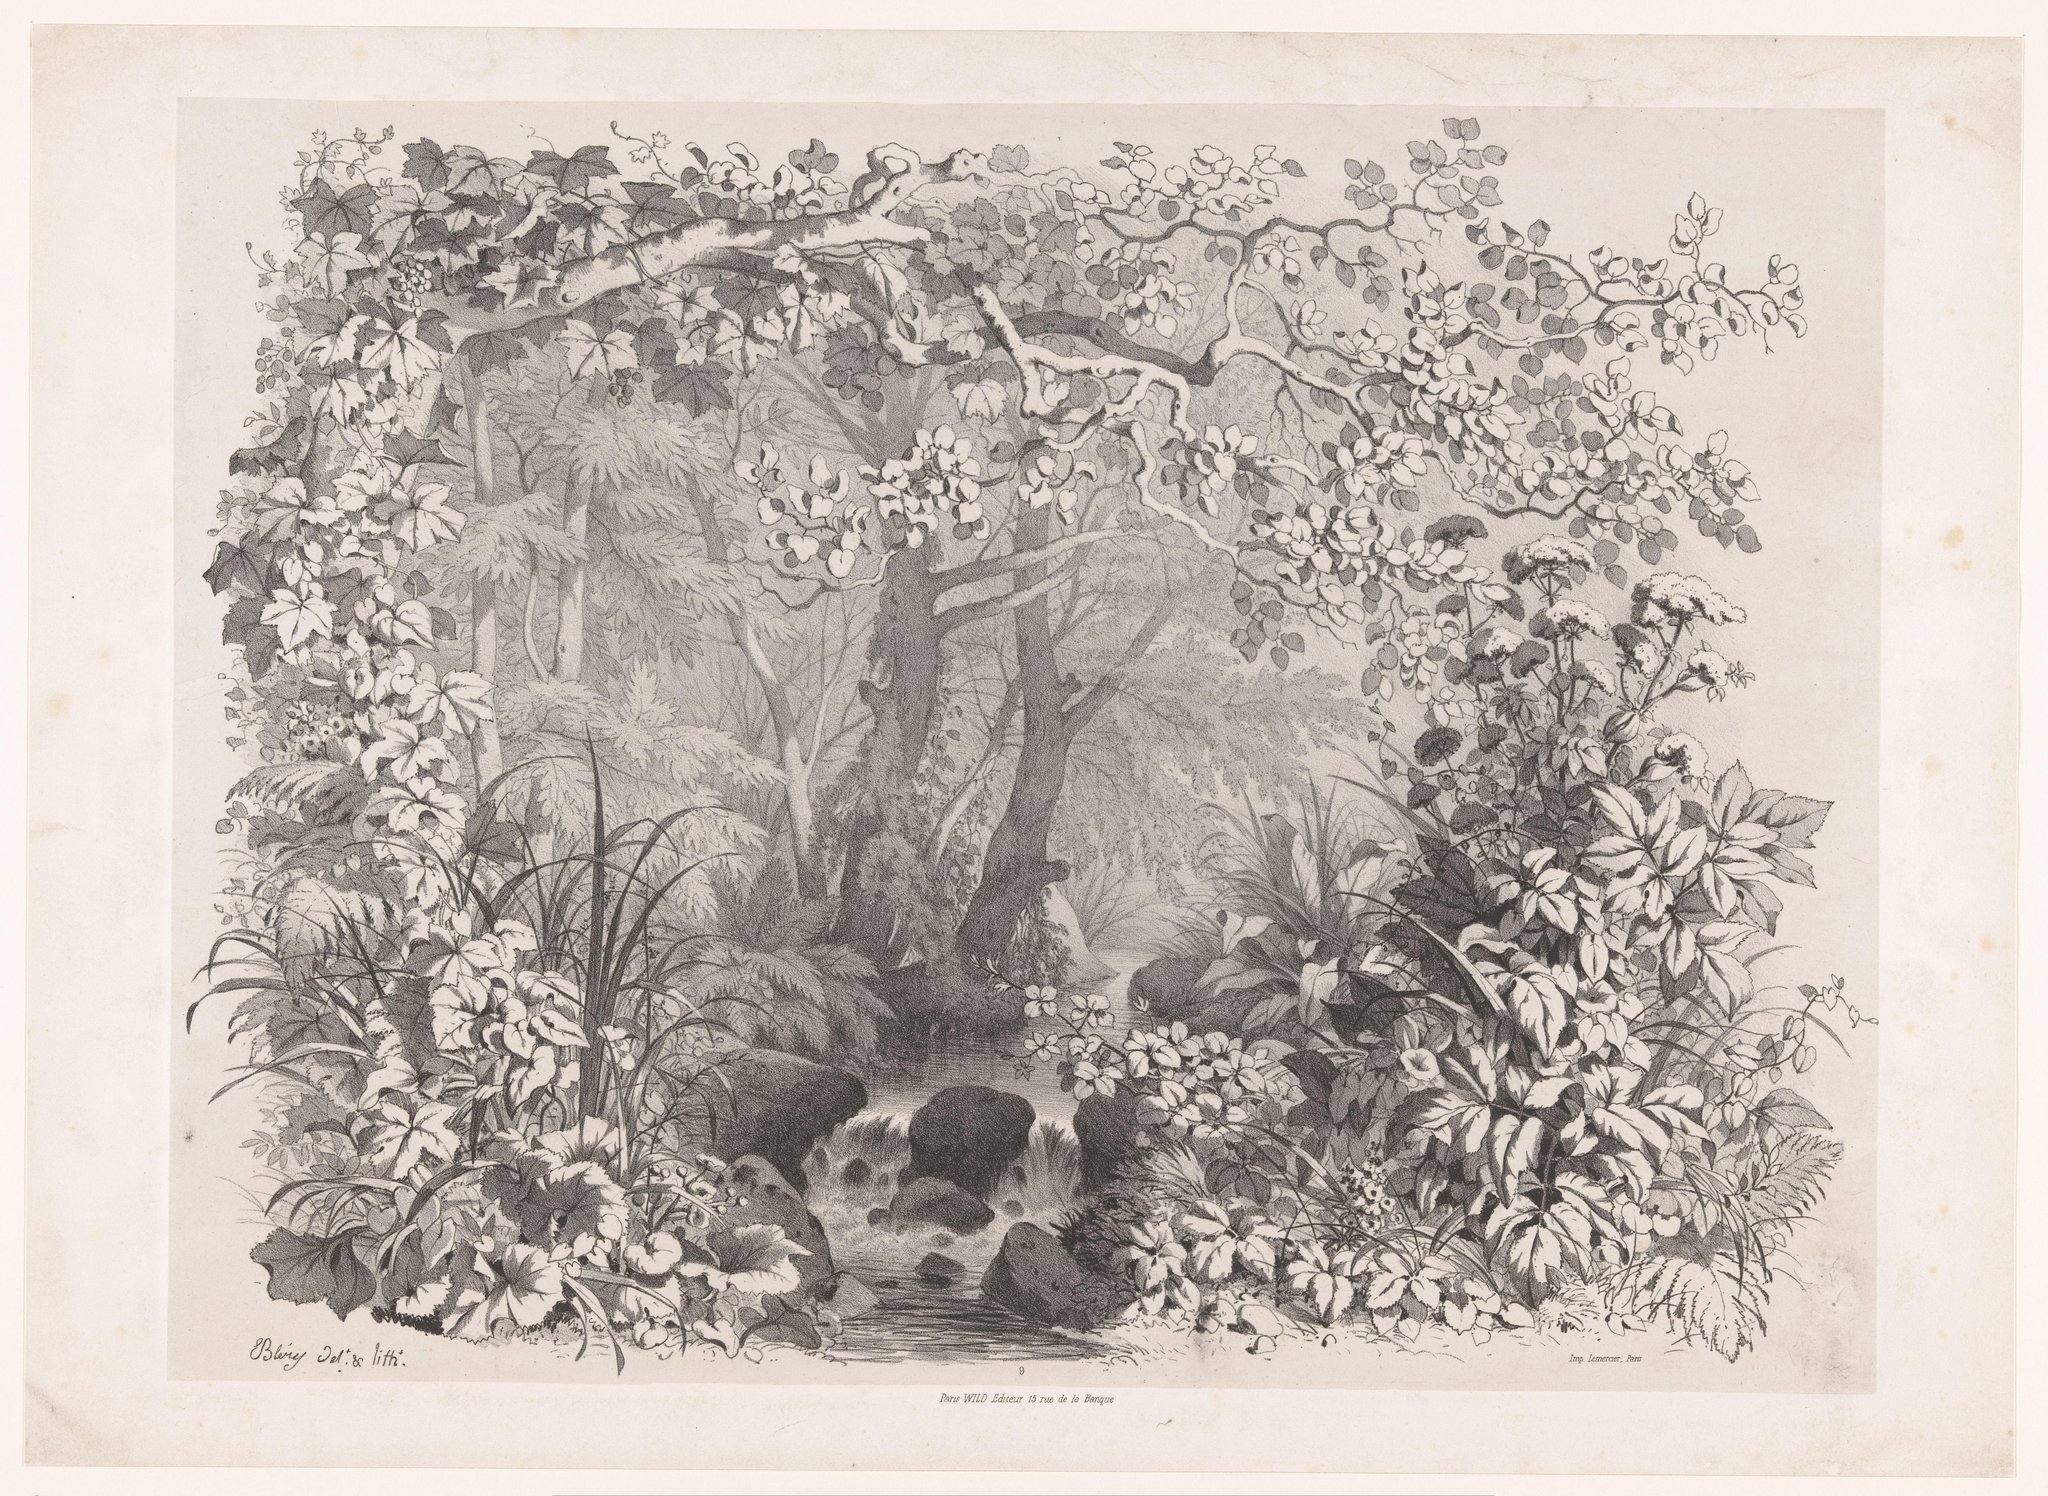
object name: print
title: Le ruisseau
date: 1856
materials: paper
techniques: lithograph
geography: paris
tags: forest, wood, brook, plants and herbs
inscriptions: collector's mark: Lugt 2228a, collector's mark: Lugt 2760